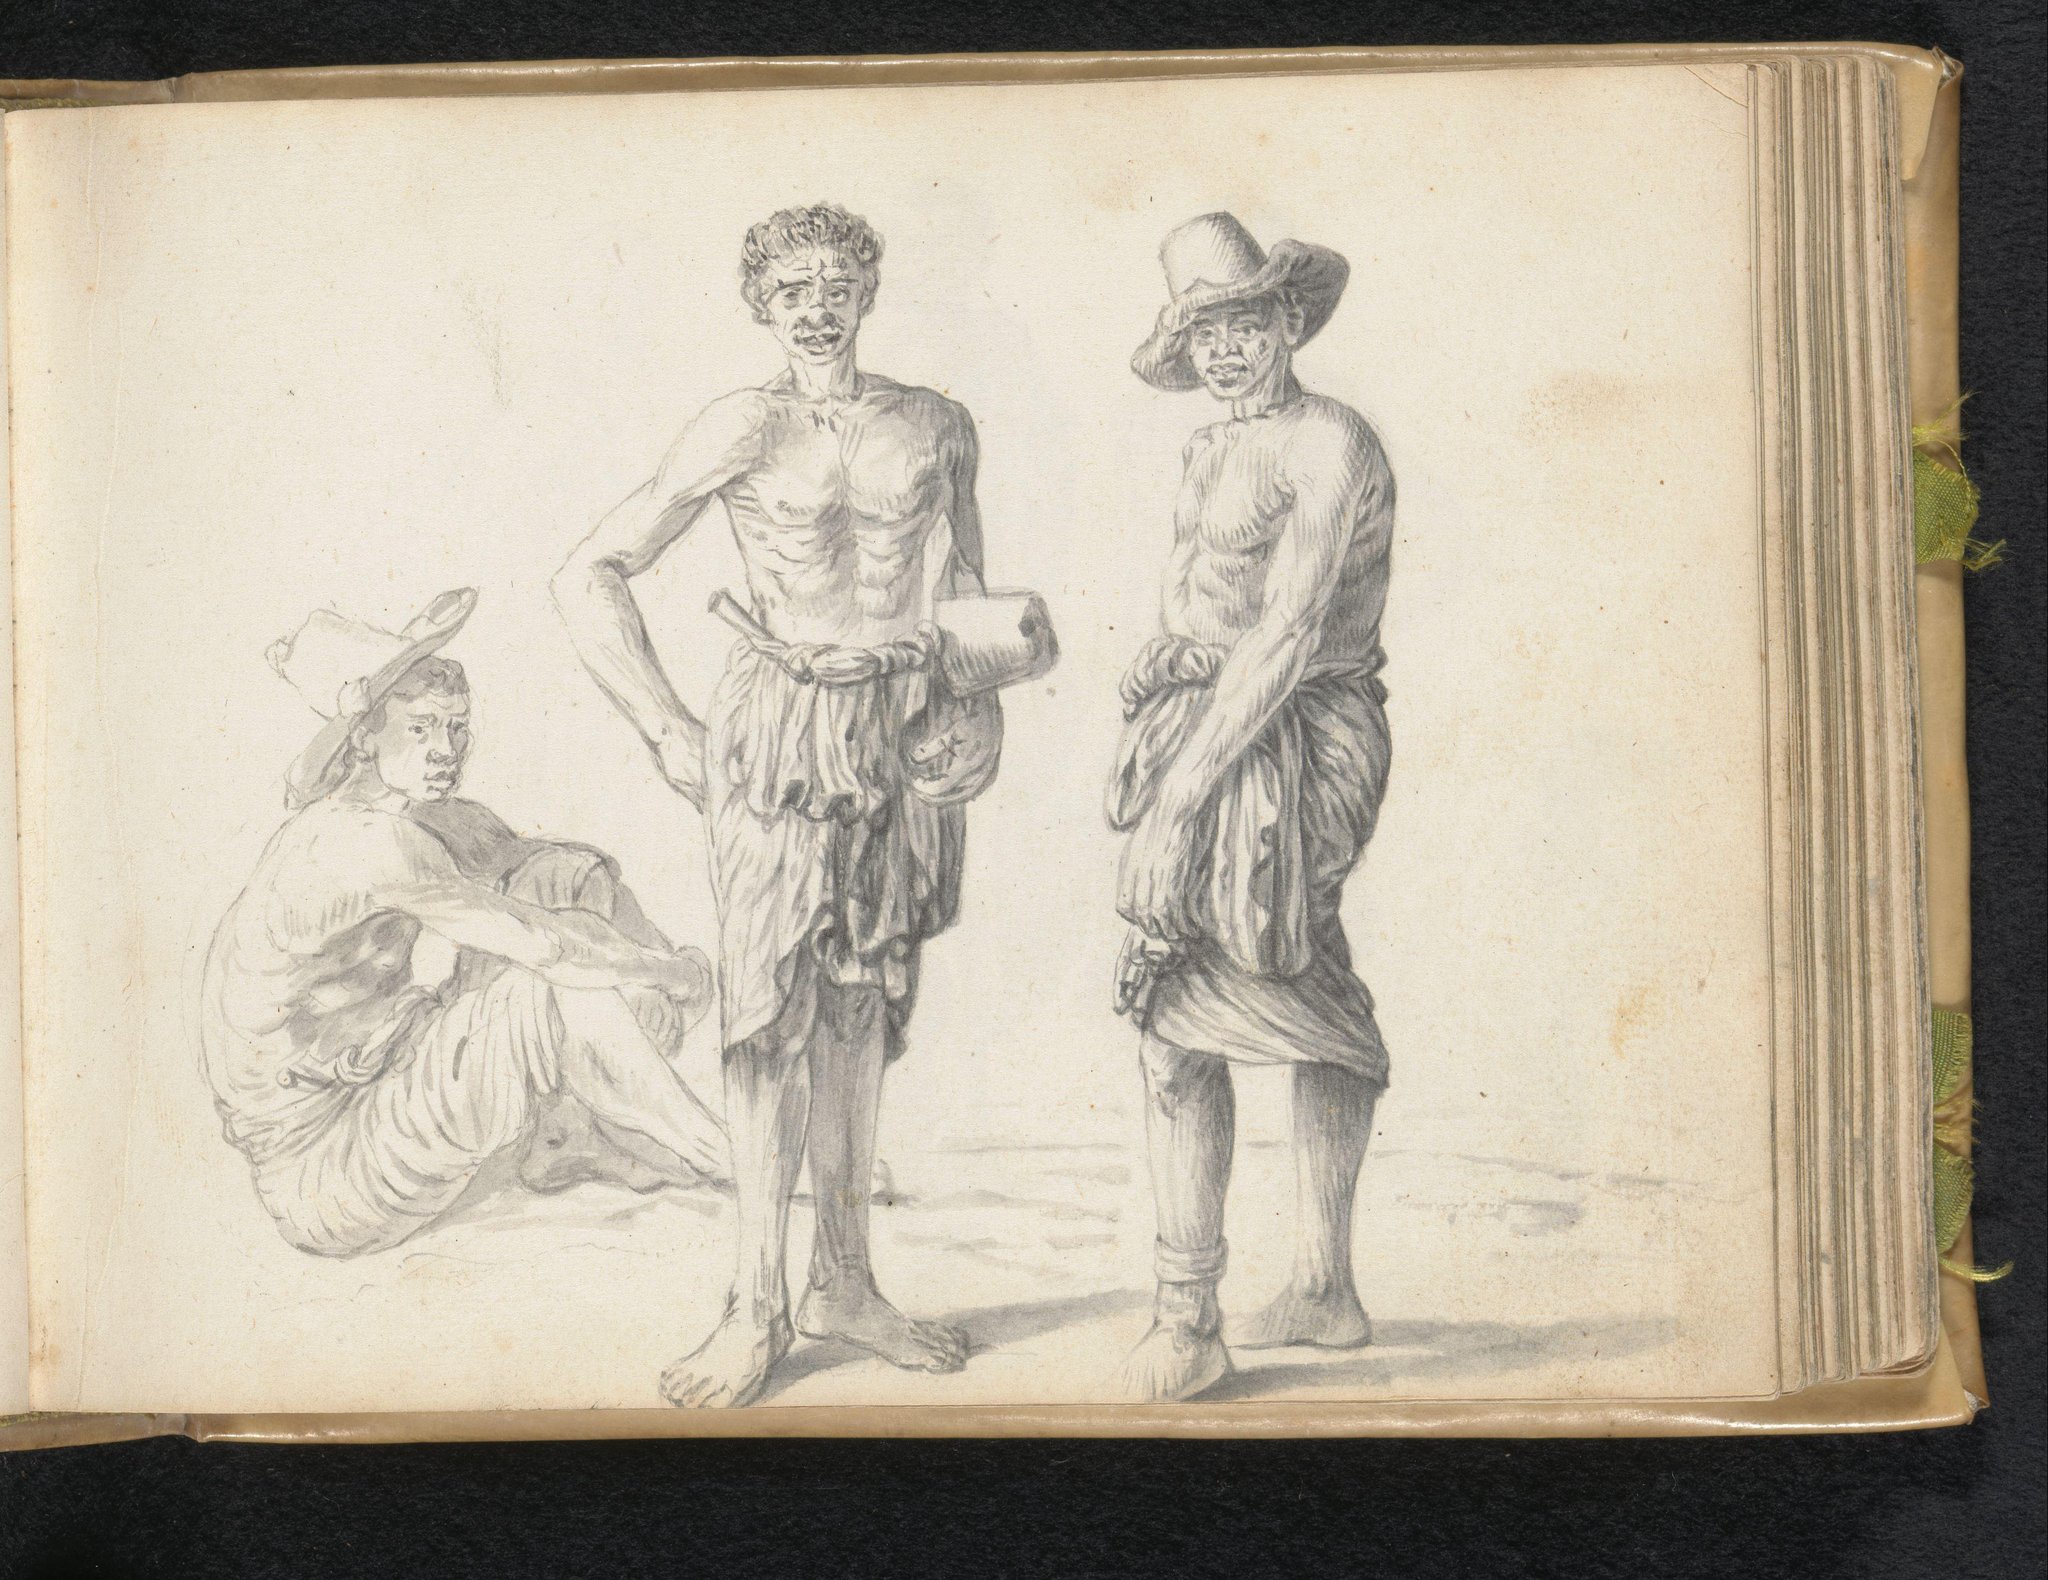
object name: sketchbook leaf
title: Three labourers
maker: esaias boursse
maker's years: 1631-1672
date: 1662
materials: ink, paper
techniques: brush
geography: sri lanka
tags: asiatic races and peoples (srilankans), 41d232(...) skirt (lungi), asian races and peoples (with name), head-gear (with name), sri lanka